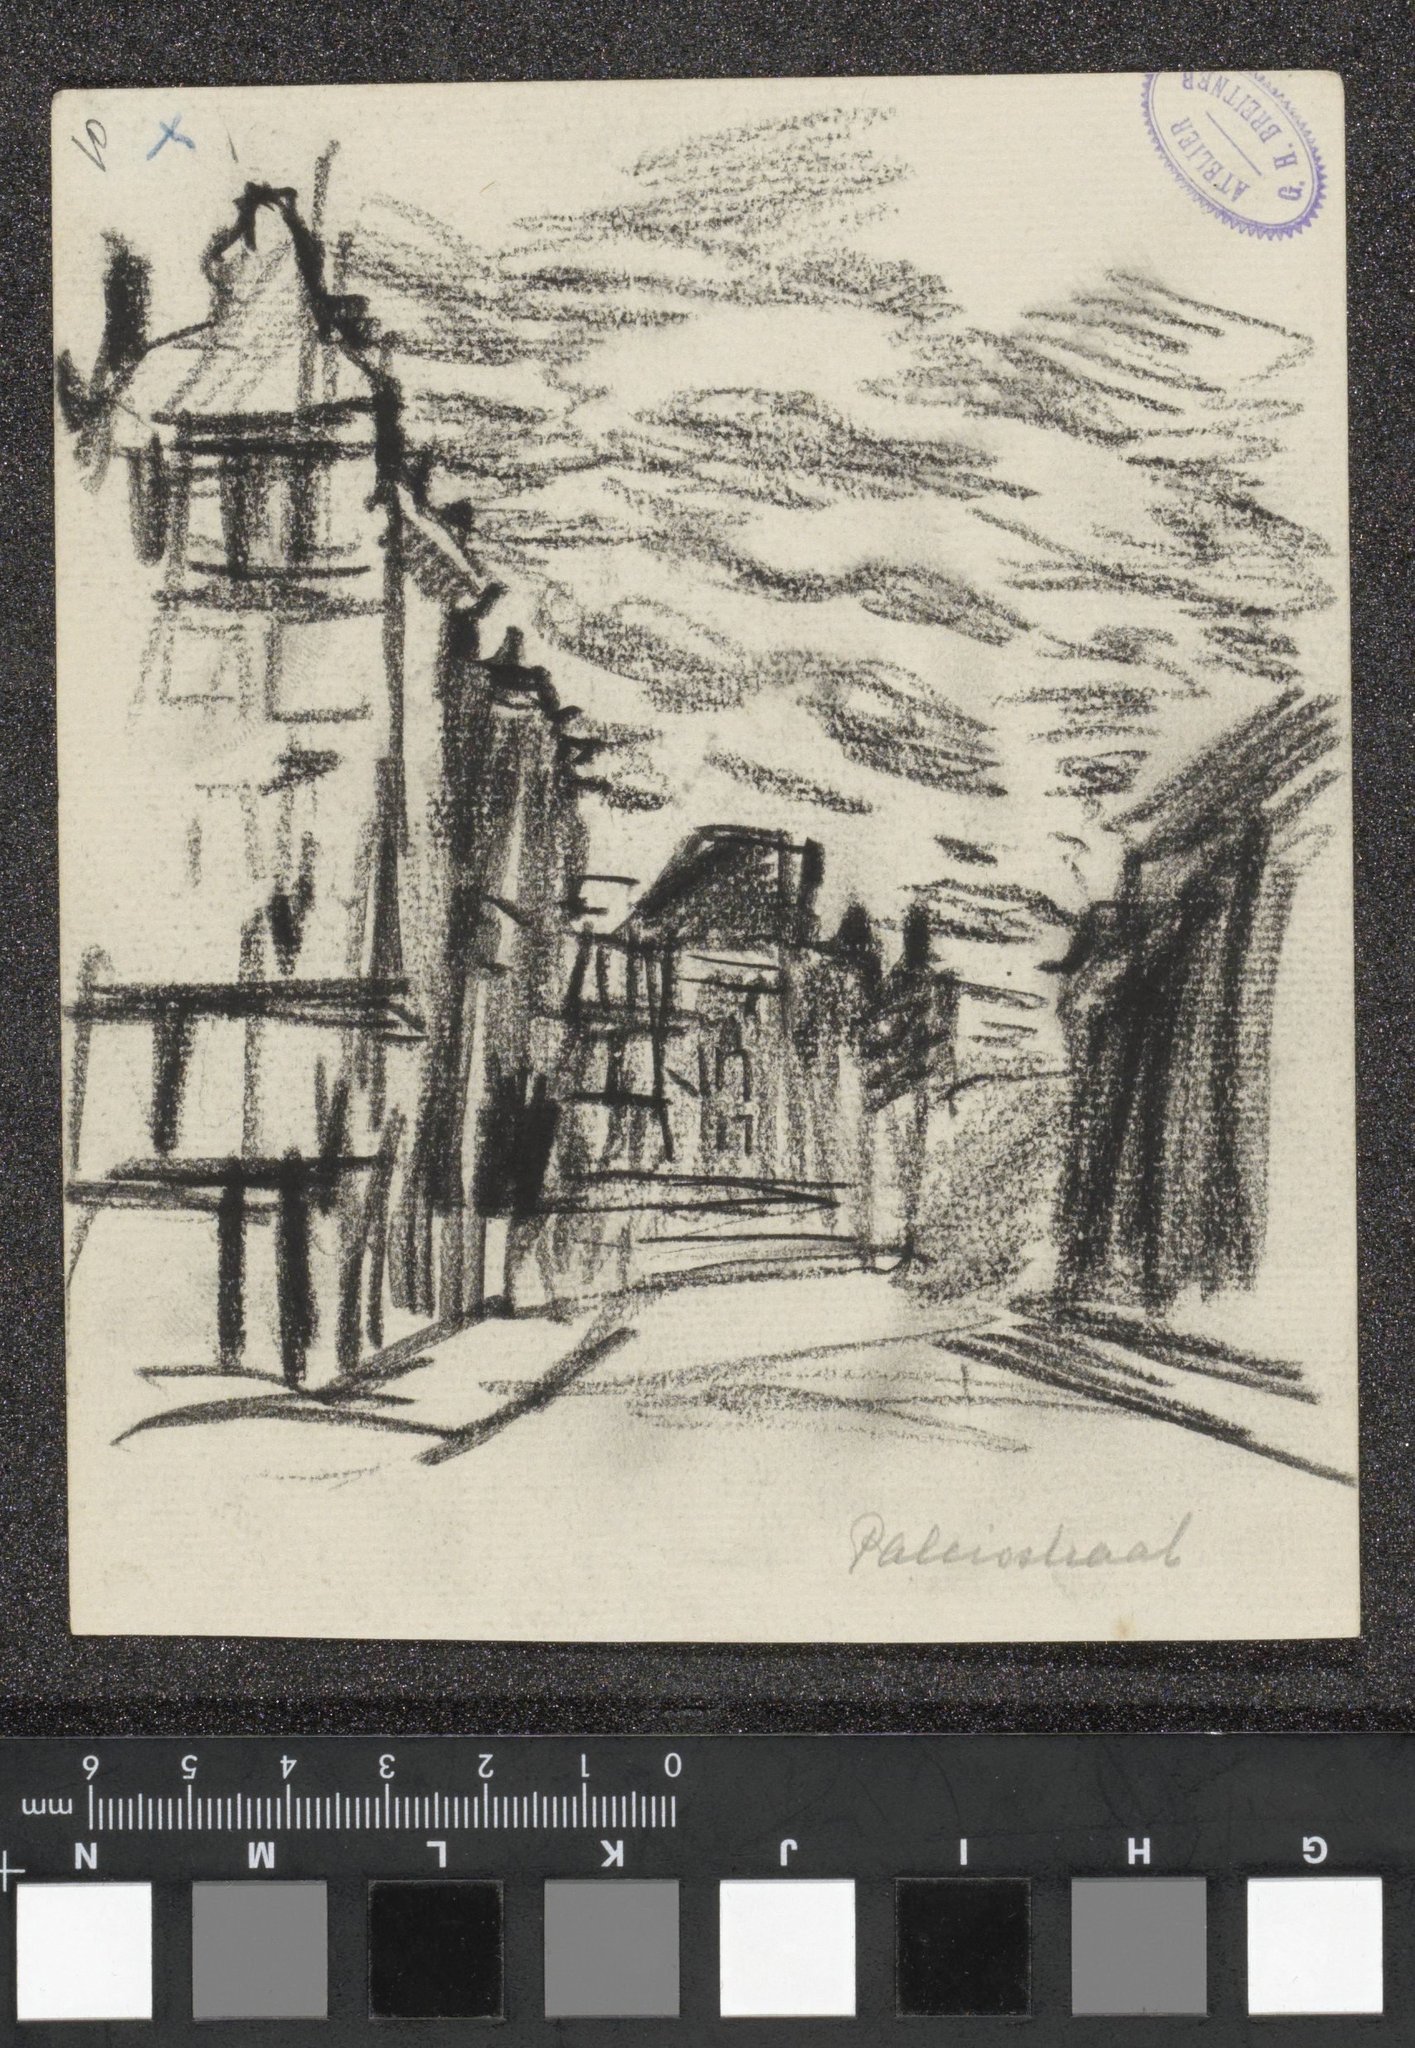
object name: drawing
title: Gezicht op de Paleisstraat te Amsterdam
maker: george hendrik breitner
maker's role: draughtsman, painter, print maker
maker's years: 1857-1923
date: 1908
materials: chalk, paper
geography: amsterdam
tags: street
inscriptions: annotation: ‘Paleisstraat’, workshop stamp: Lugt 291d